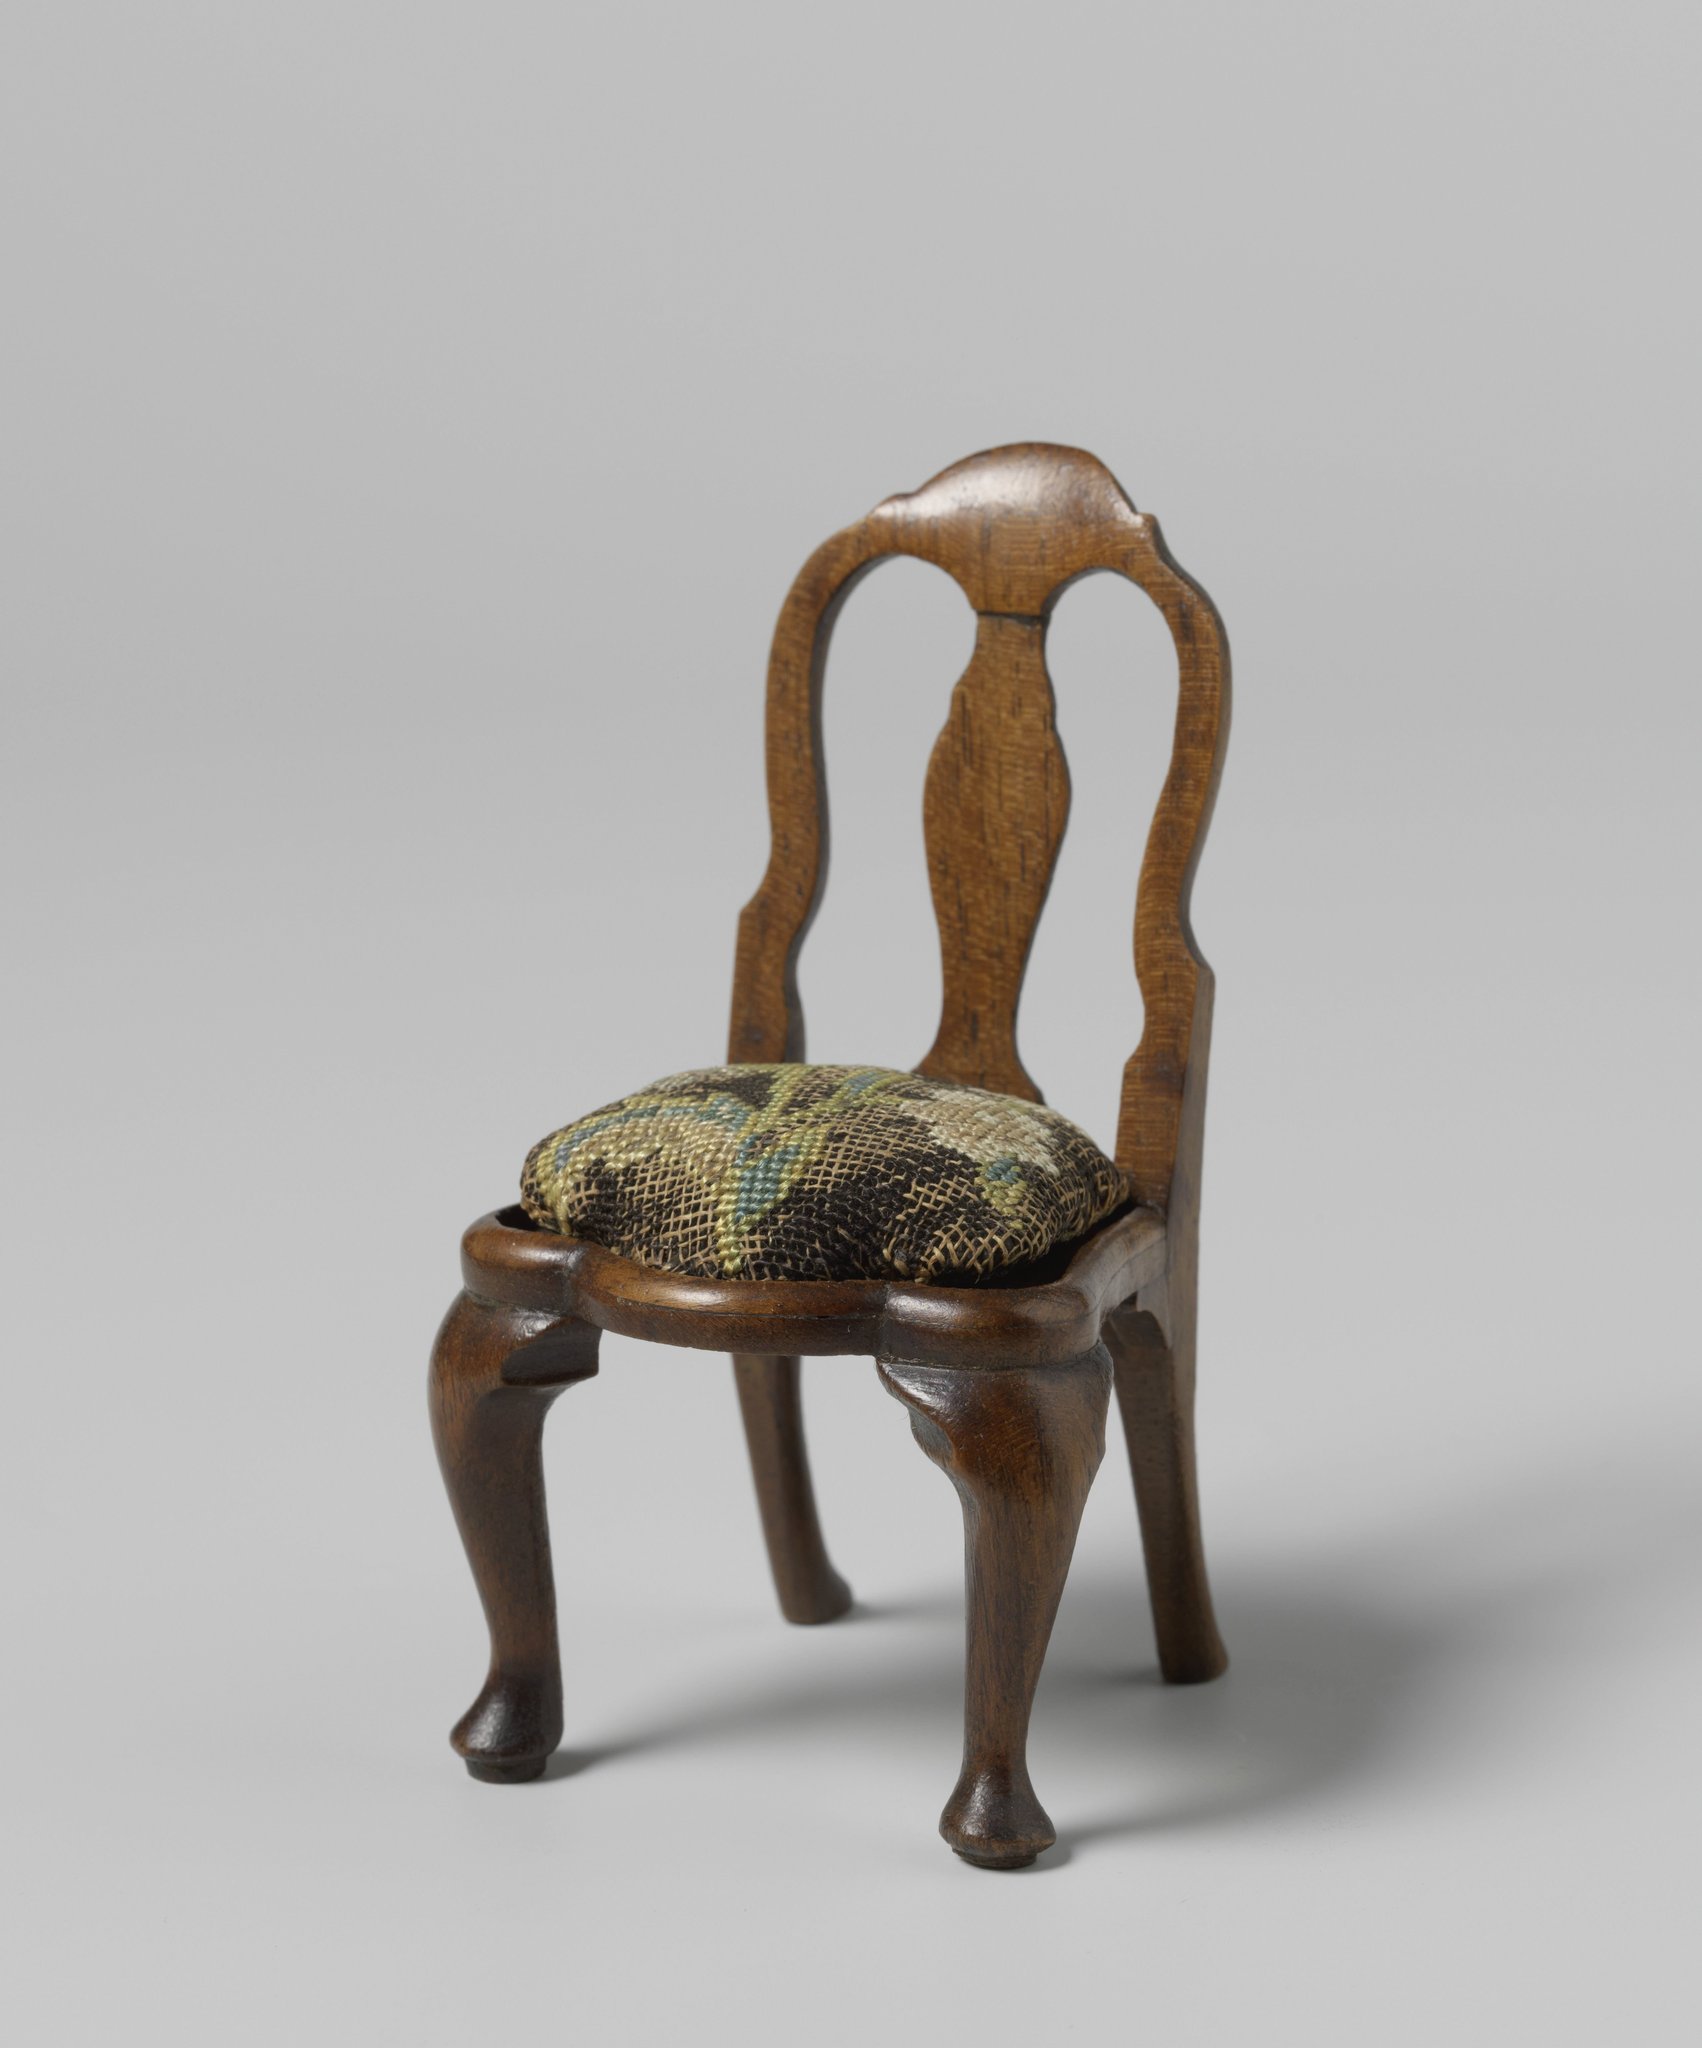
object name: miniature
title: Stoel, behorend tot een elfdelig ameublement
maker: Anonymous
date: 1750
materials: silk, wood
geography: amsterdam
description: Stoel, vervaardigd van notenhout, behorend tot een elfdelig ameublement, bestaande uit een bank en tien stoelen. De zitting van buurduurwerk met blad- en bloemmotieven in zijde op linnen stramien, met een zachte vulling.